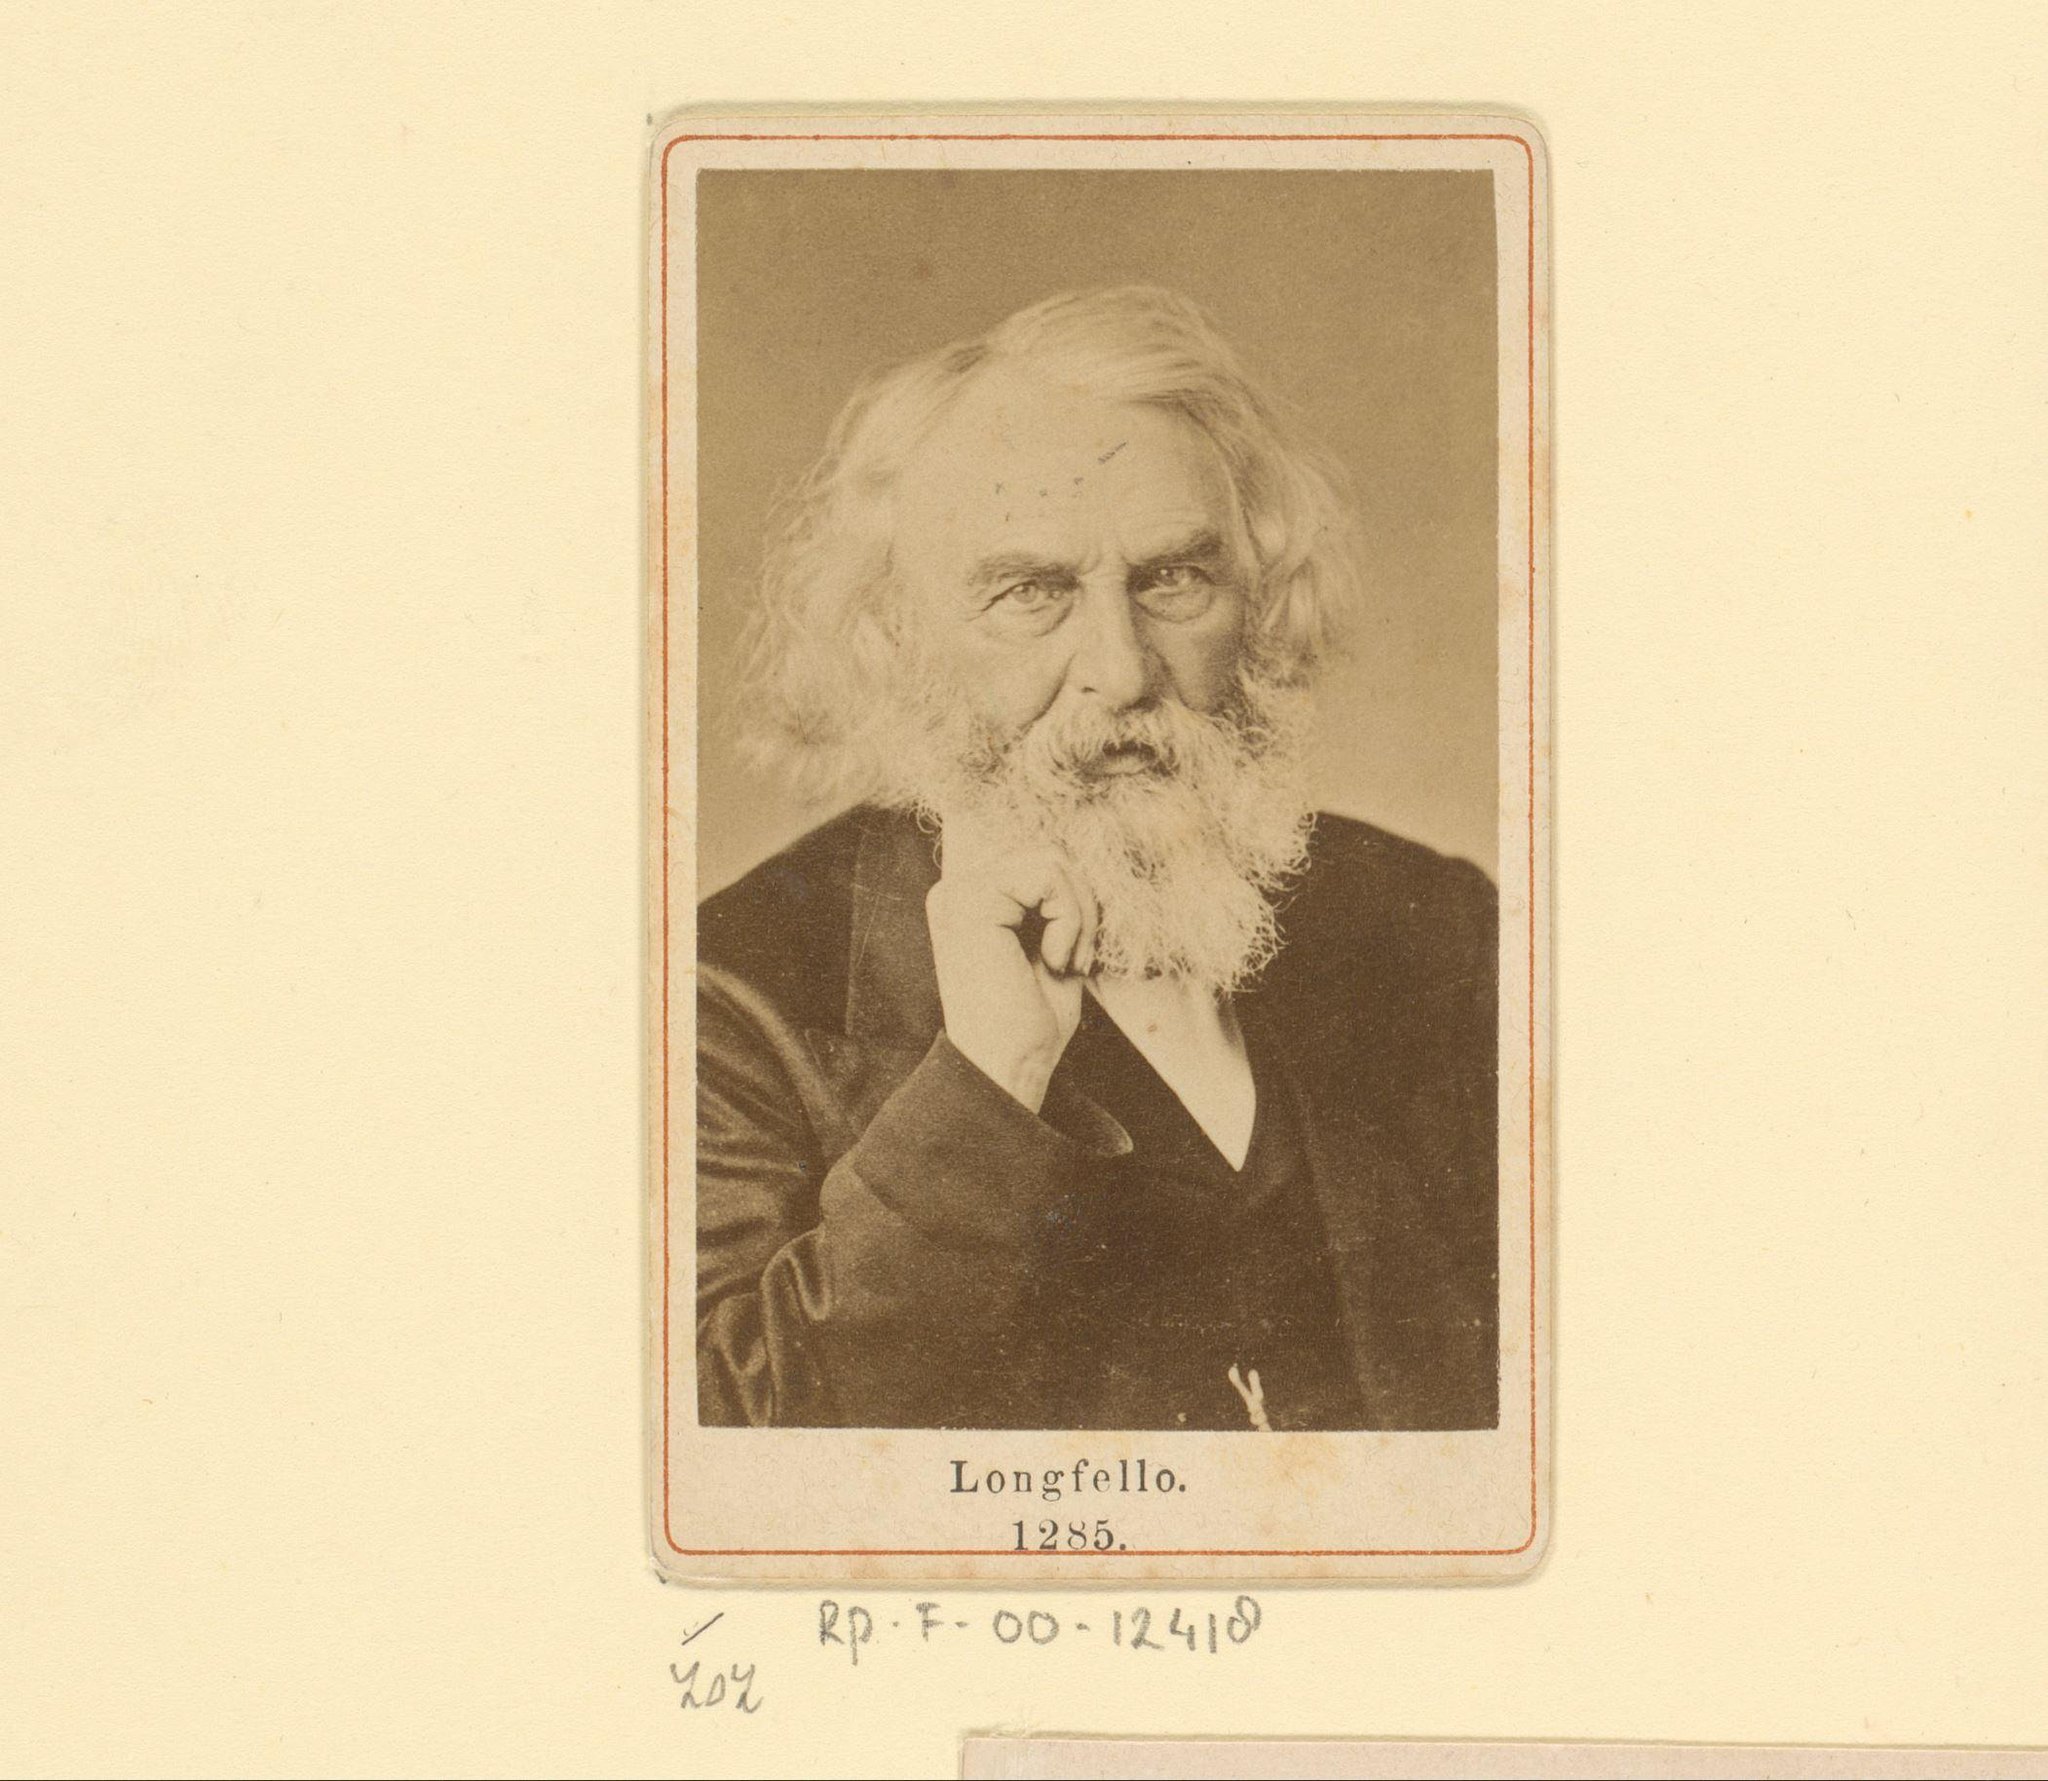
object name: photograph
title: Portret van Henry Wadsworth Longfellow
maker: Anonymous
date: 1870-1882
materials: cardboard, paper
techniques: albumen print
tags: henry wadsworth longfellow, portrait of a writer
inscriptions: number: ‘1285.’, inscription: ‘f.’